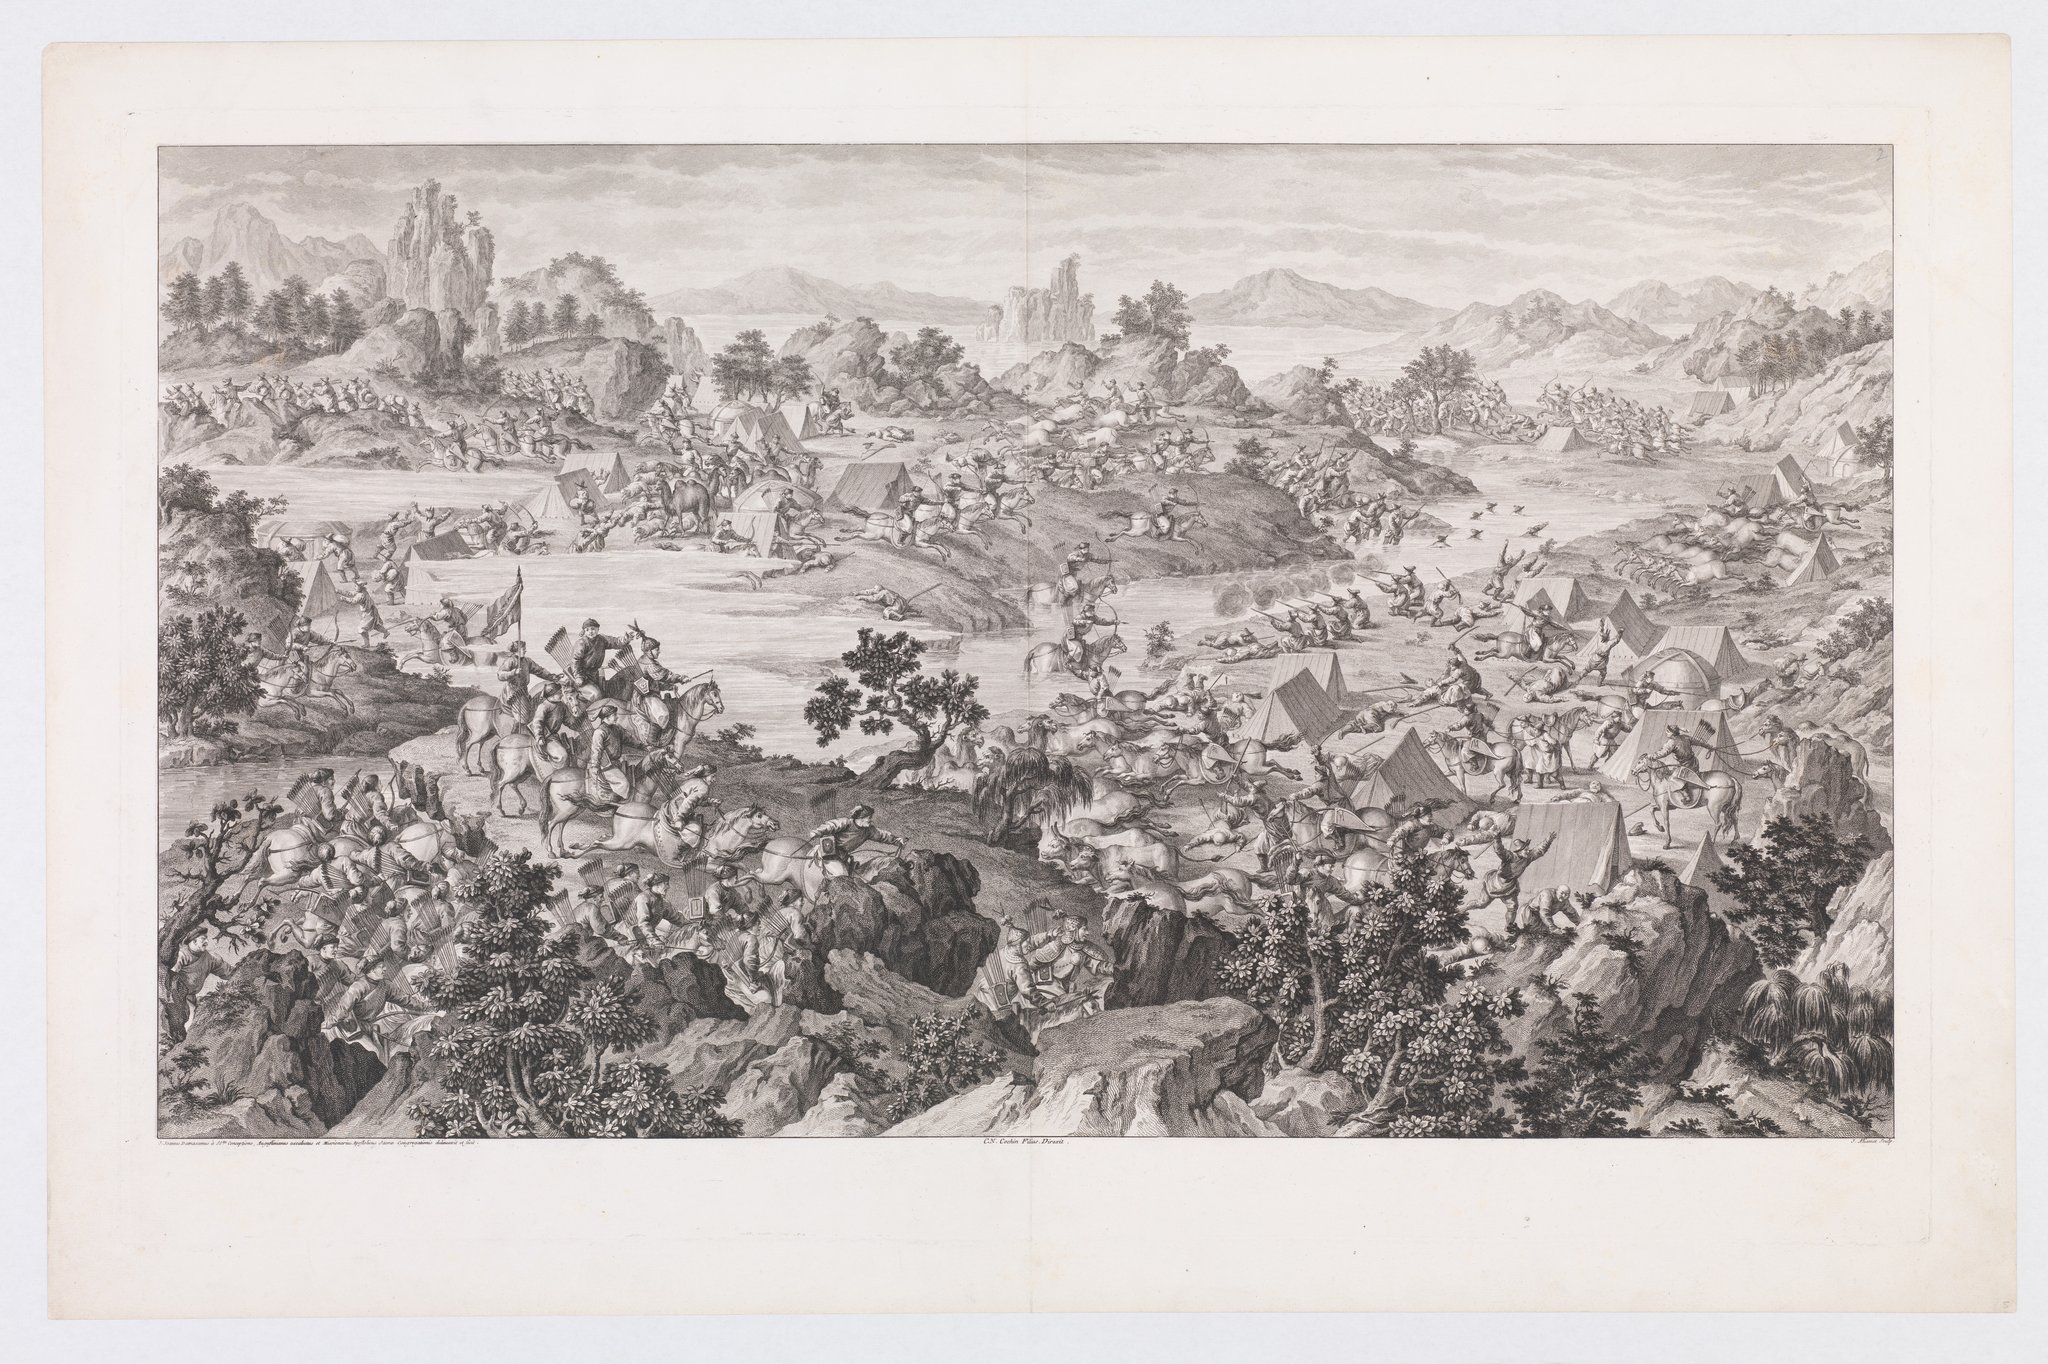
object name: print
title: The Combat of Khurungui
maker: jacques aliamet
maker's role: artist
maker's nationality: french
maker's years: 1726-1788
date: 1774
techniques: engraving, etching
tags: tents,battles,soldiers,bow and arrow,horses